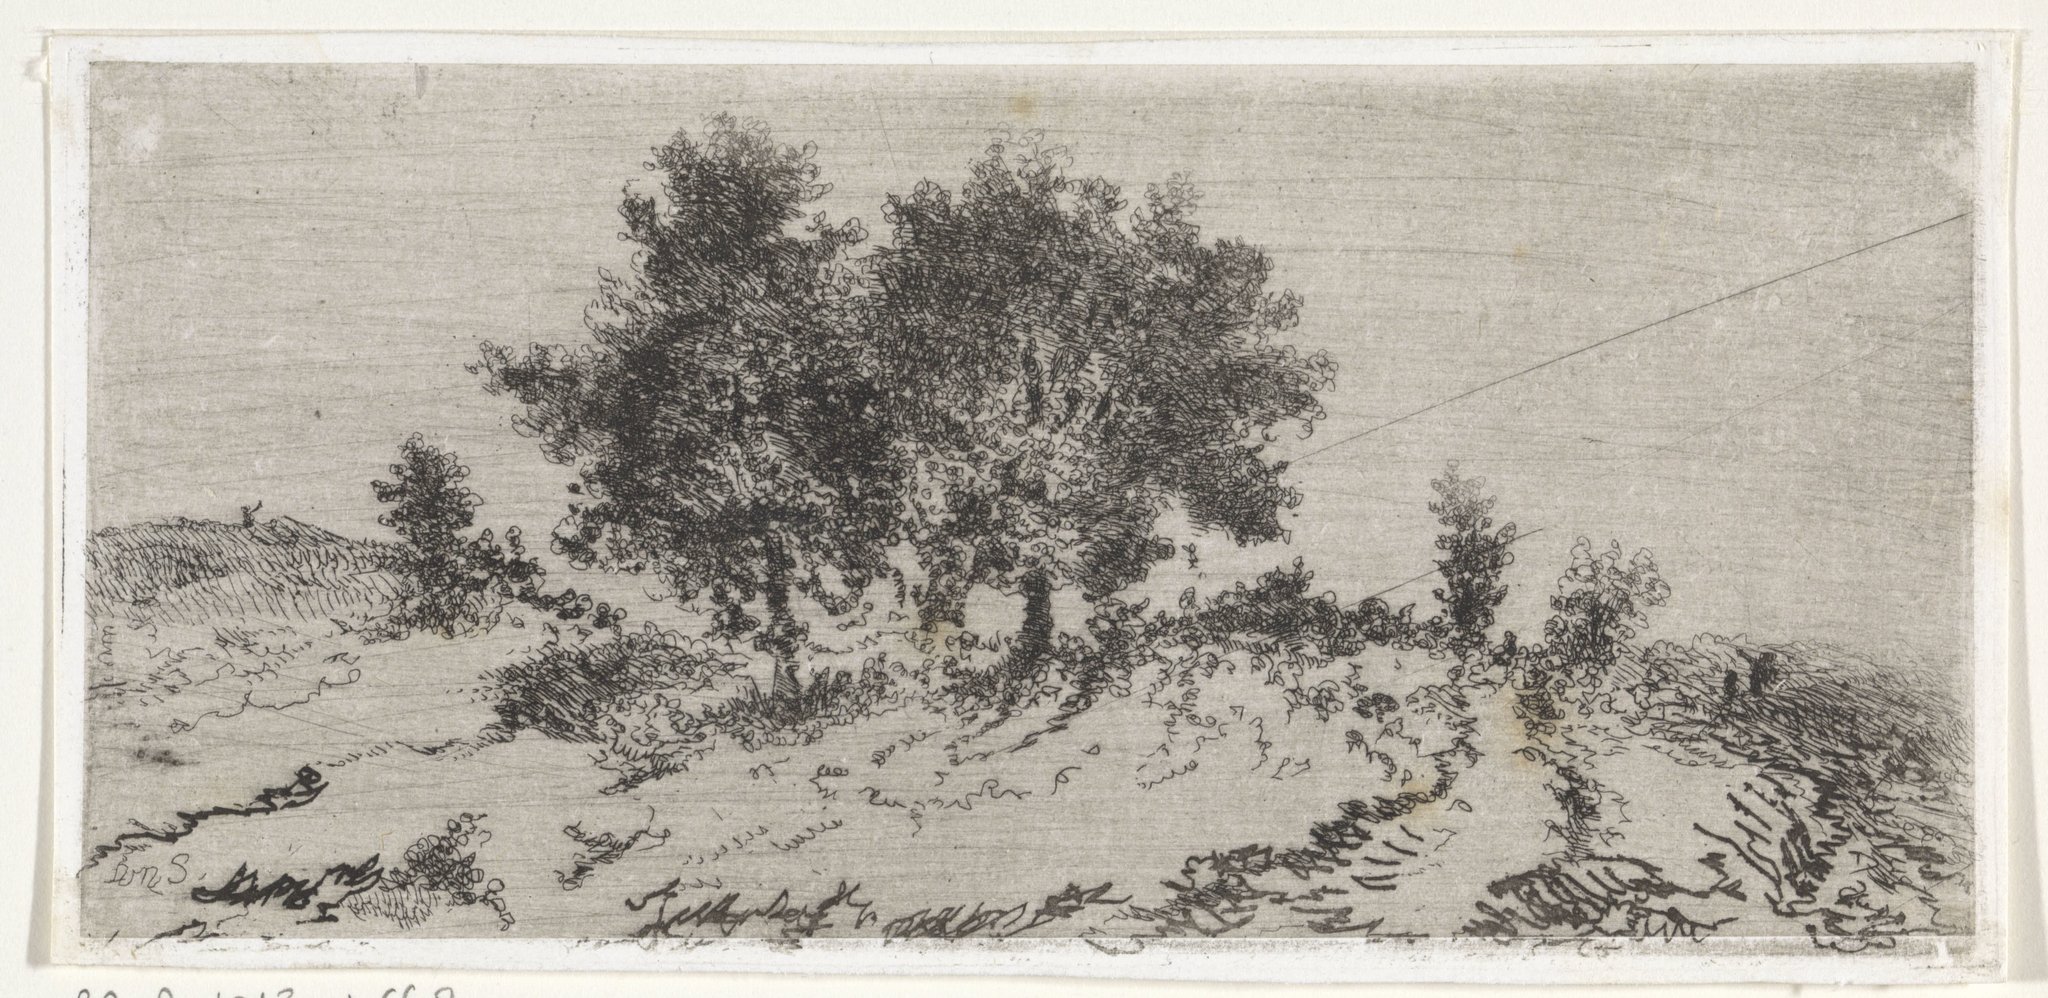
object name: print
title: Landschap met bomengroep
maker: arnoud schaepkens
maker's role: print maker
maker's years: 1816-1904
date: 1855-1904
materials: paper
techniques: drypoint, etching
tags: landscapes in the temperate zone - hh - ideal landscapes, trees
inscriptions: collector's mark: Lugt 2228